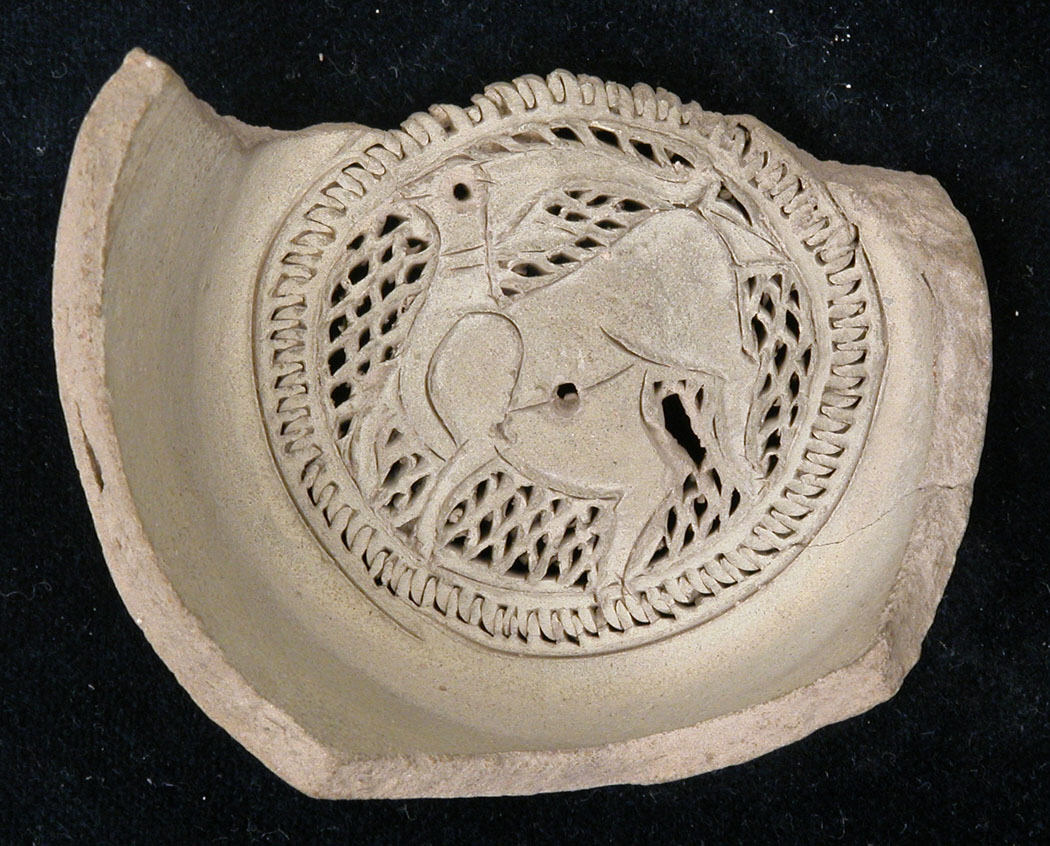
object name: water filter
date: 901-1200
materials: earthenware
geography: egypt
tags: animals